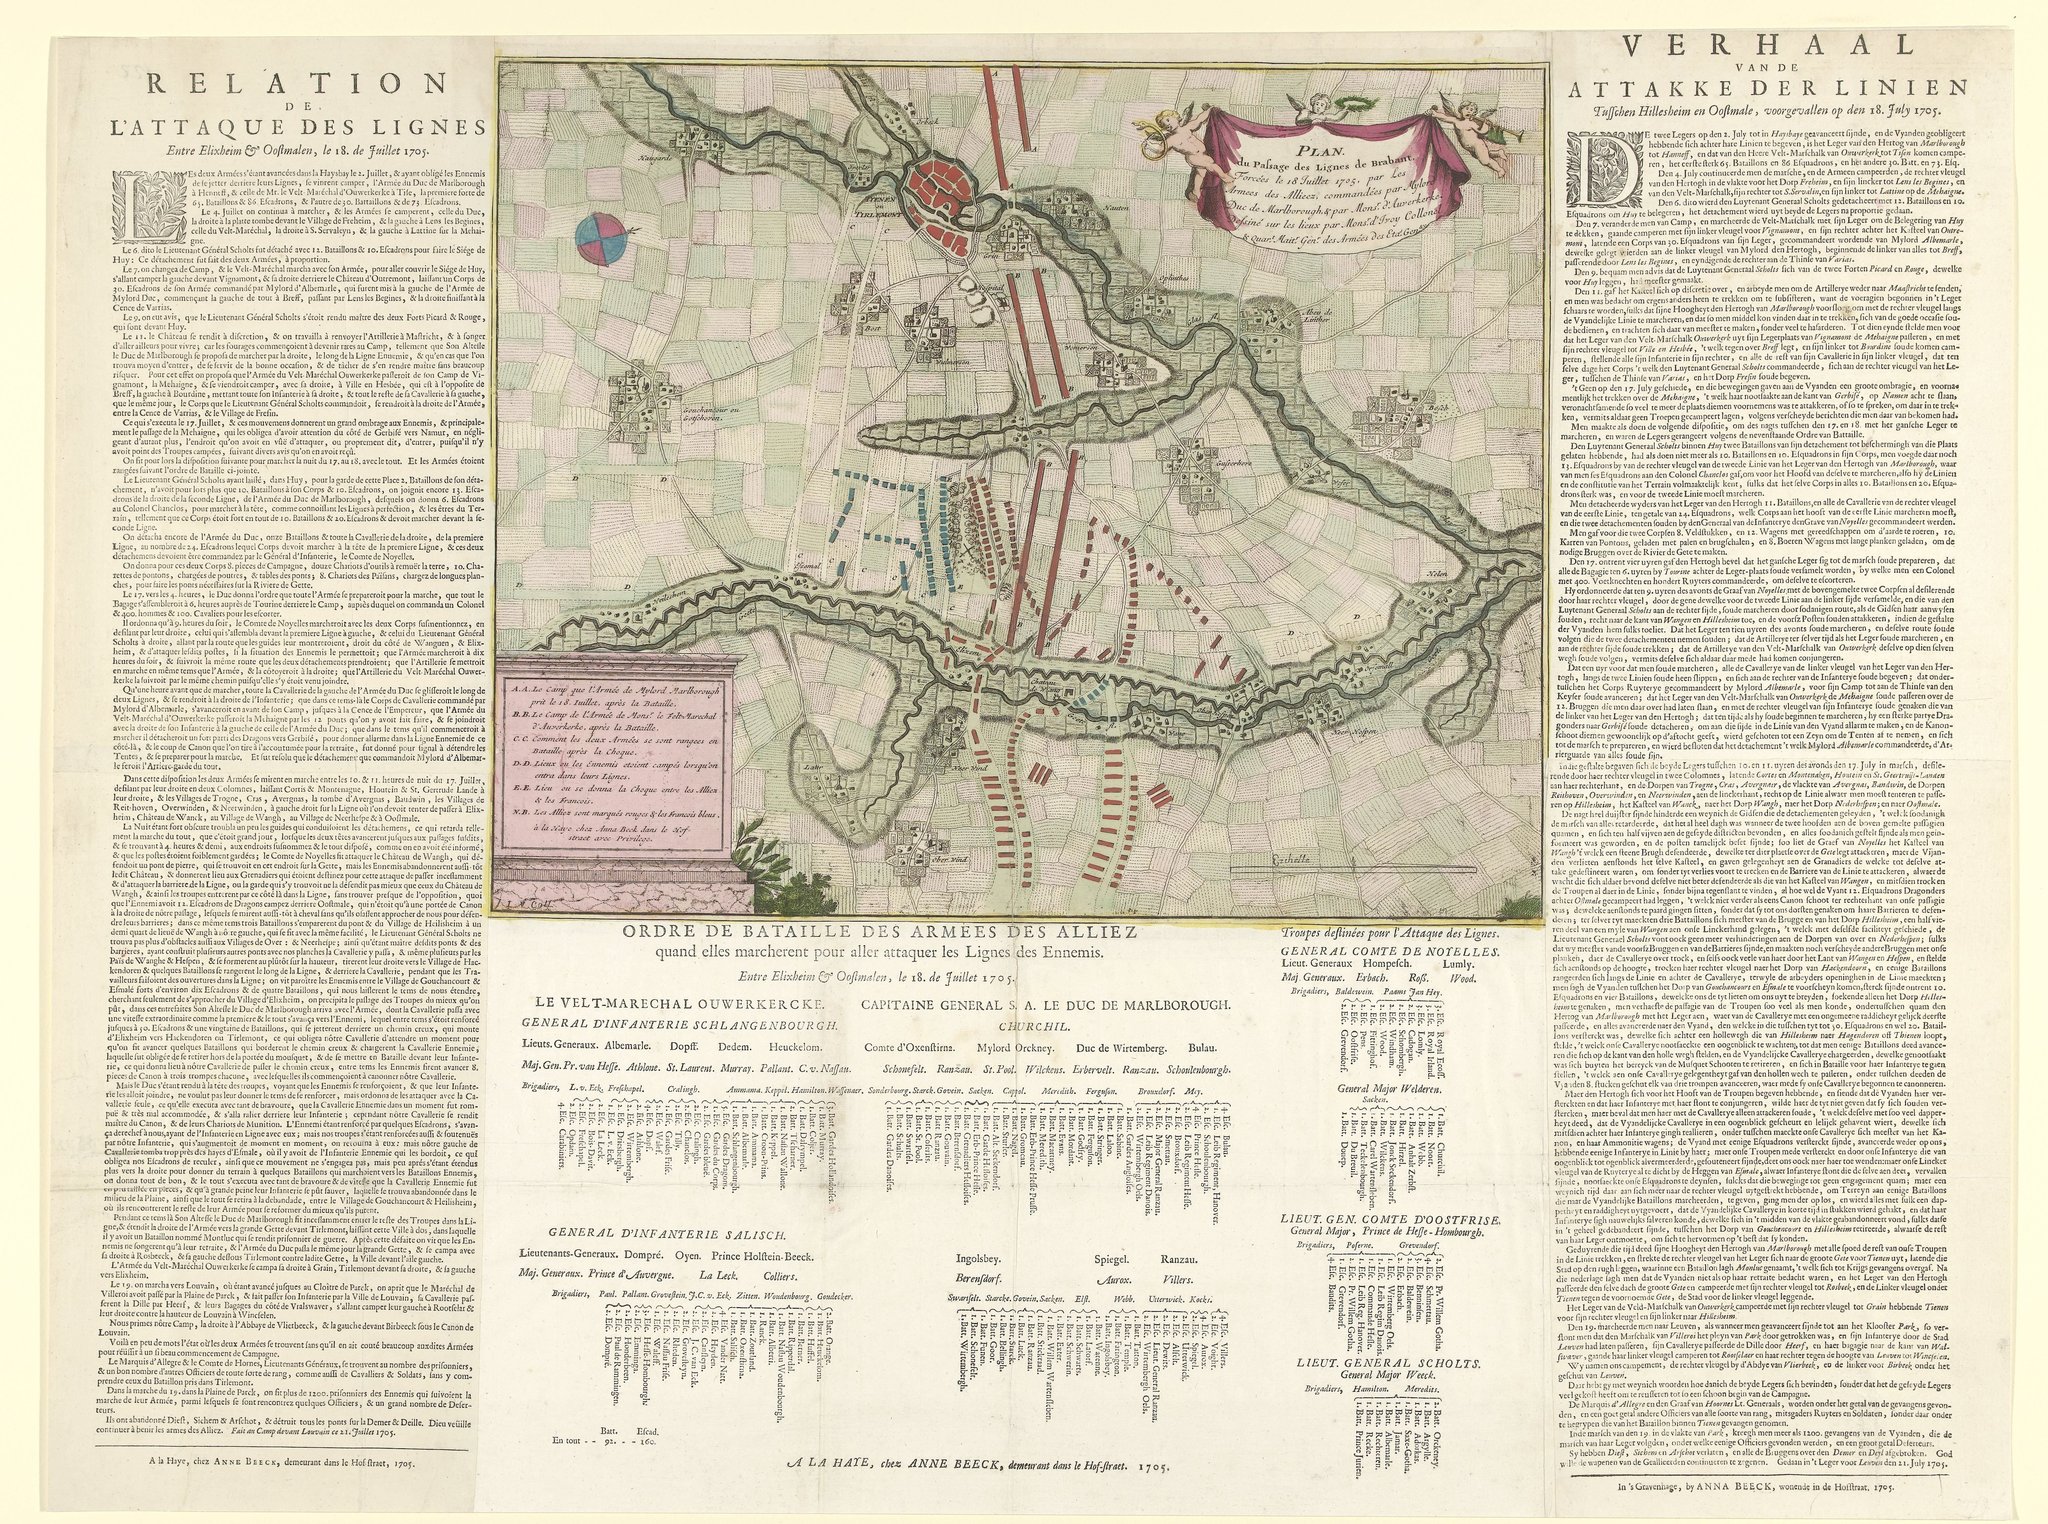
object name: print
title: Doorbraak van de Franse linies in Brabant, 1705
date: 1705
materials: paper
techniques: etching, hand coloring, letterpress printing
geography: the hague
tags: john churchill (1e hertog van marlborough), the hague, maps of cities, battle (+ land forces)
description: Kaart van de doorbraak van de Franse linies in Brabant door de Geallieerden onder de hertog van Marlborough en de Heer van Ouwerkerk, 18 juli 1705. Vastgeplakt onder de kaart is een blad met de slagorde van de Geallieerden, links en rechts een beschrijving van de aanval in het Frans en Nederlands. Linksonder de legenda AA-EE in het Frans.